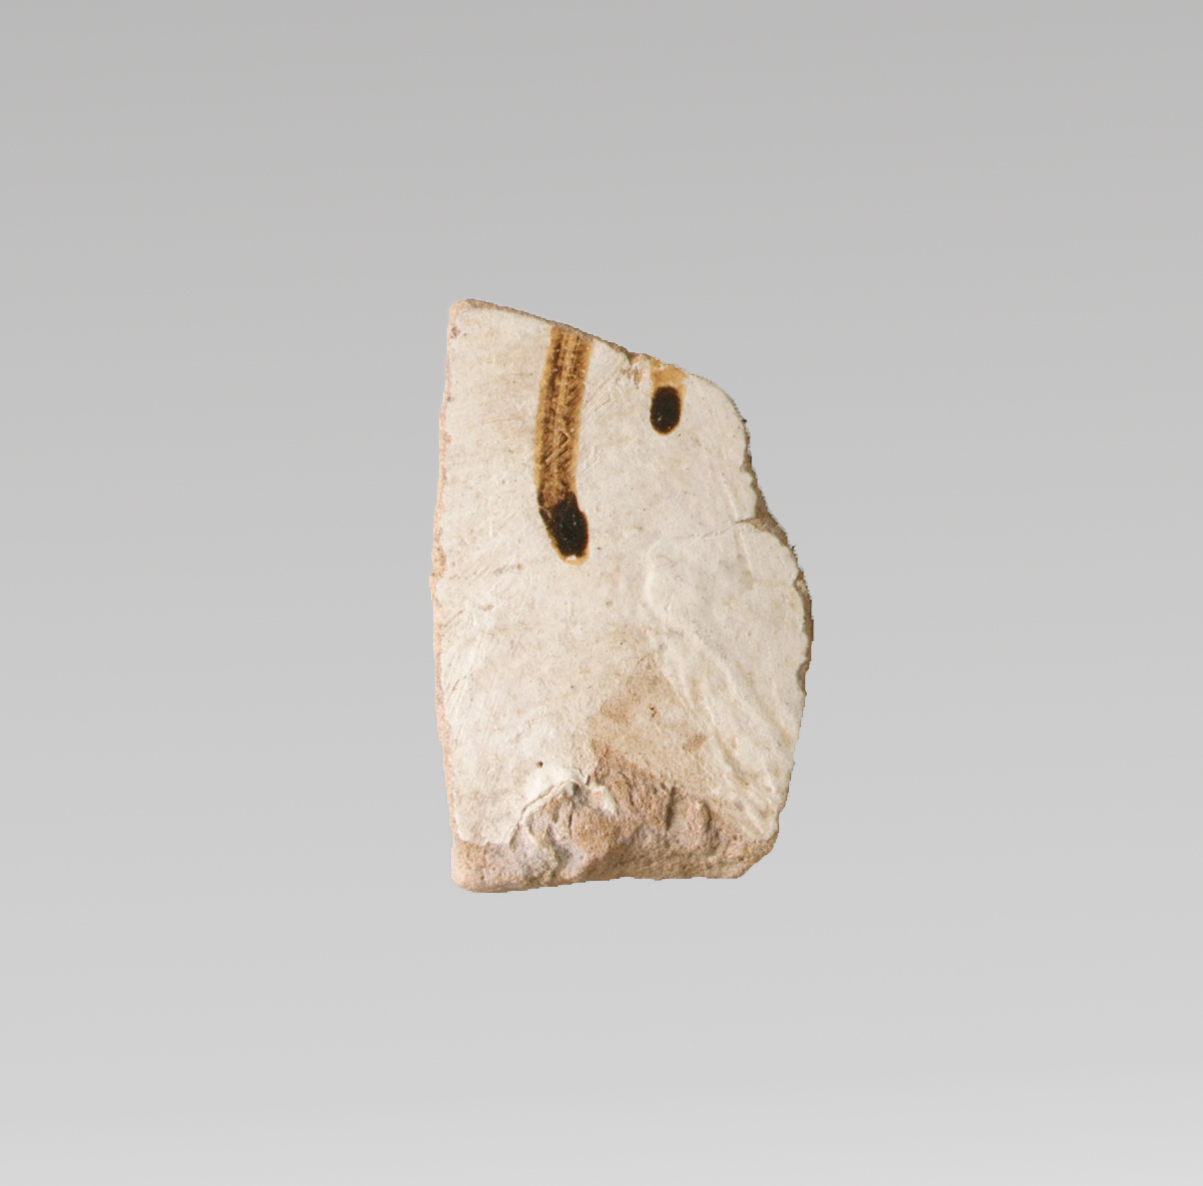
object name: vase fragment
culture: east greek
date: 700-601 BCE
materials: terracotta